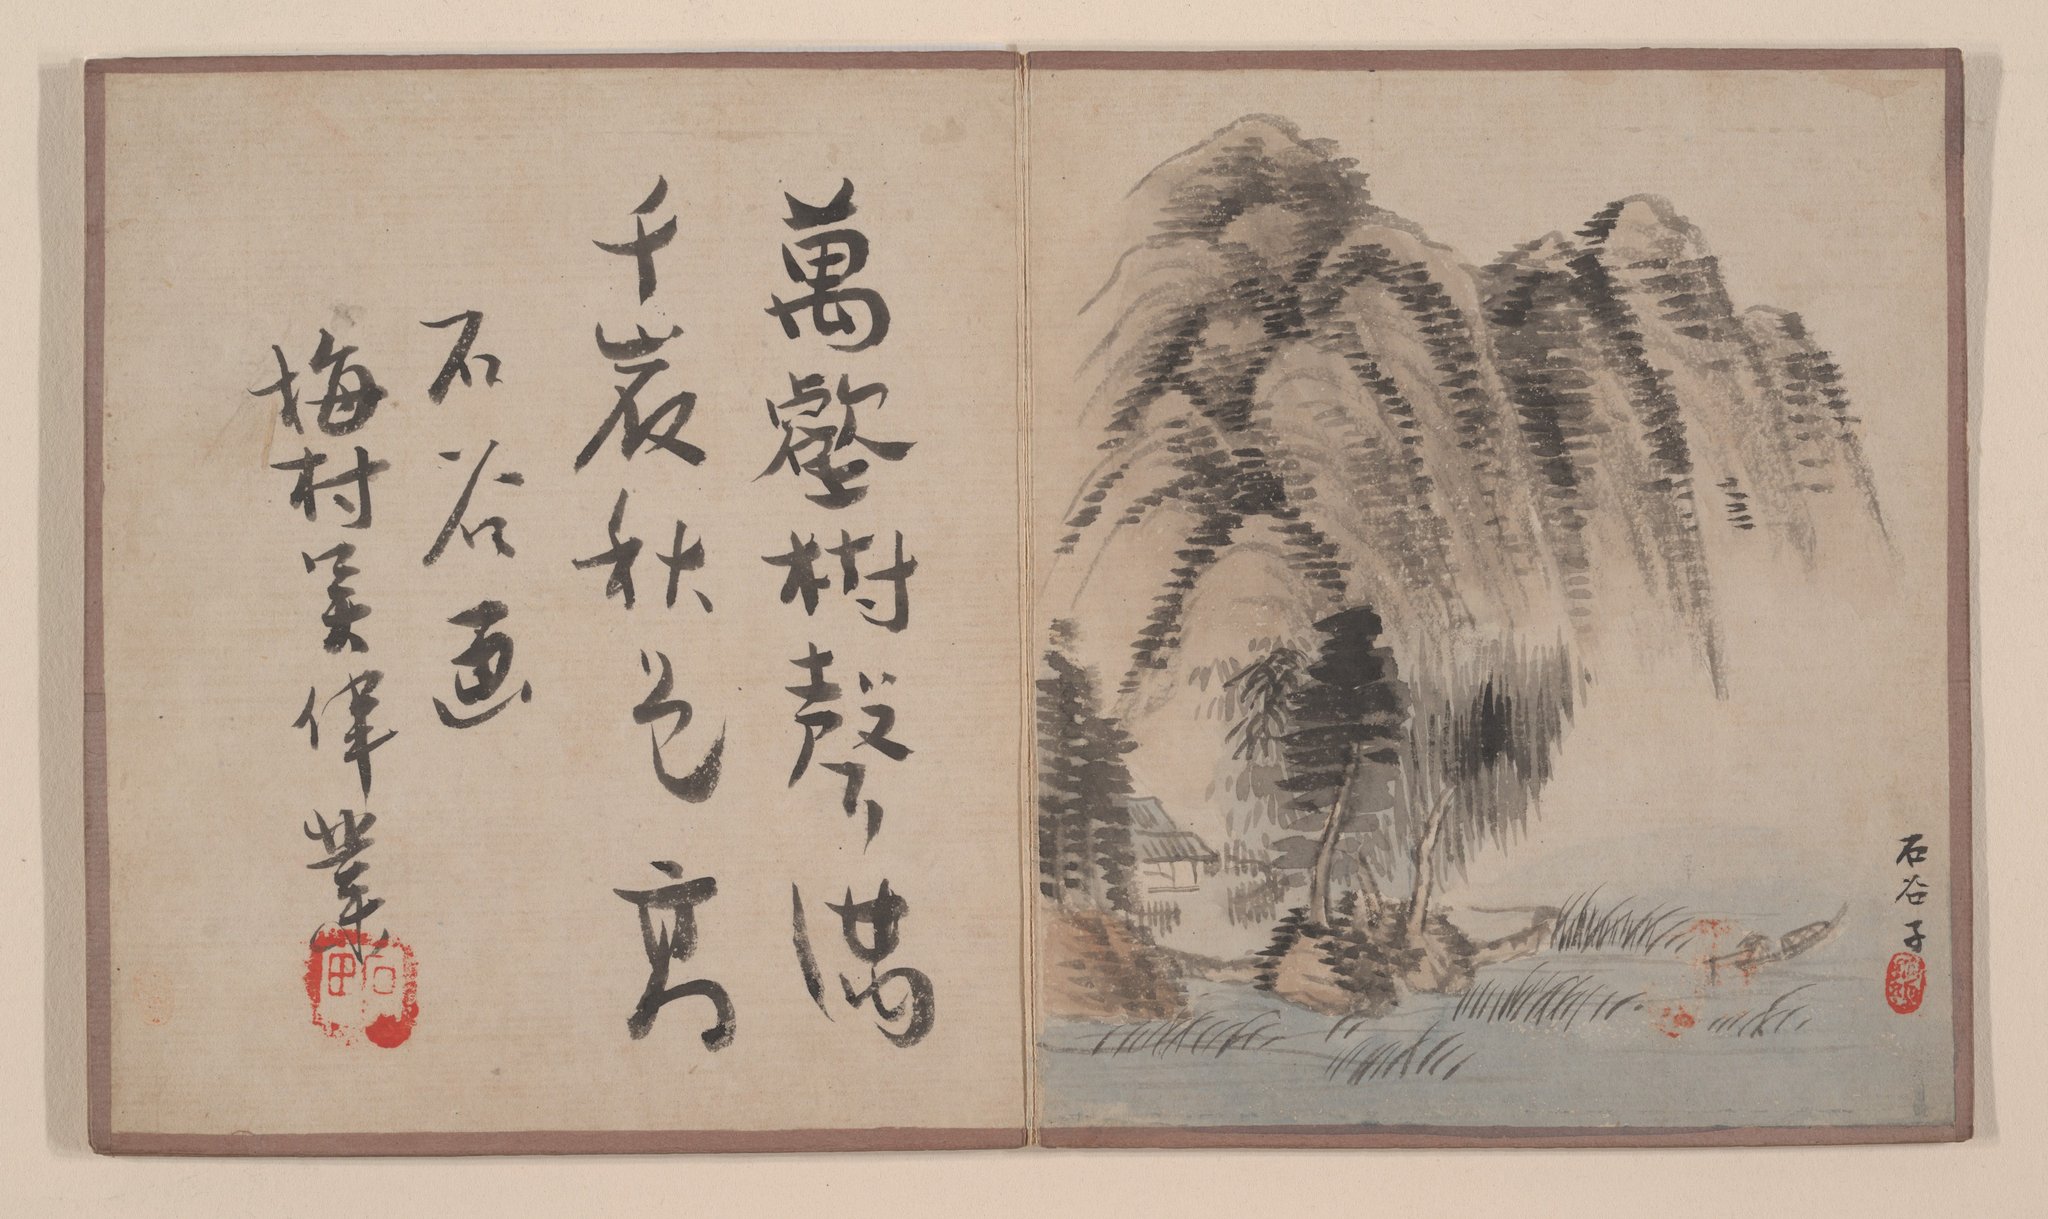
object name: album leaf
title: Eight album leaves from a miniature album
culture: chinese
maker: prince cheng yongxing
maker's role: artist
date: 1736-1795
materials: ink, paper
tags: landscapes